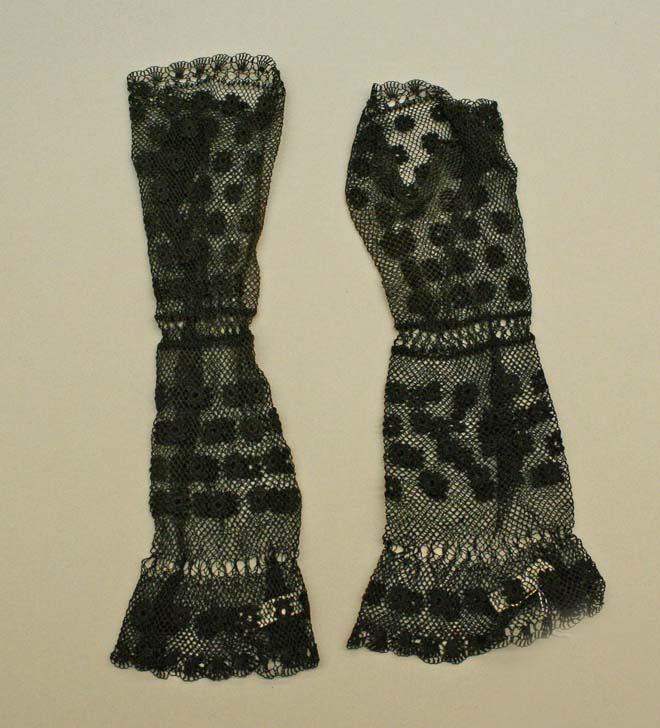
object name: mitt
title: Mitts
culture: american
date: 1850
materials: silk